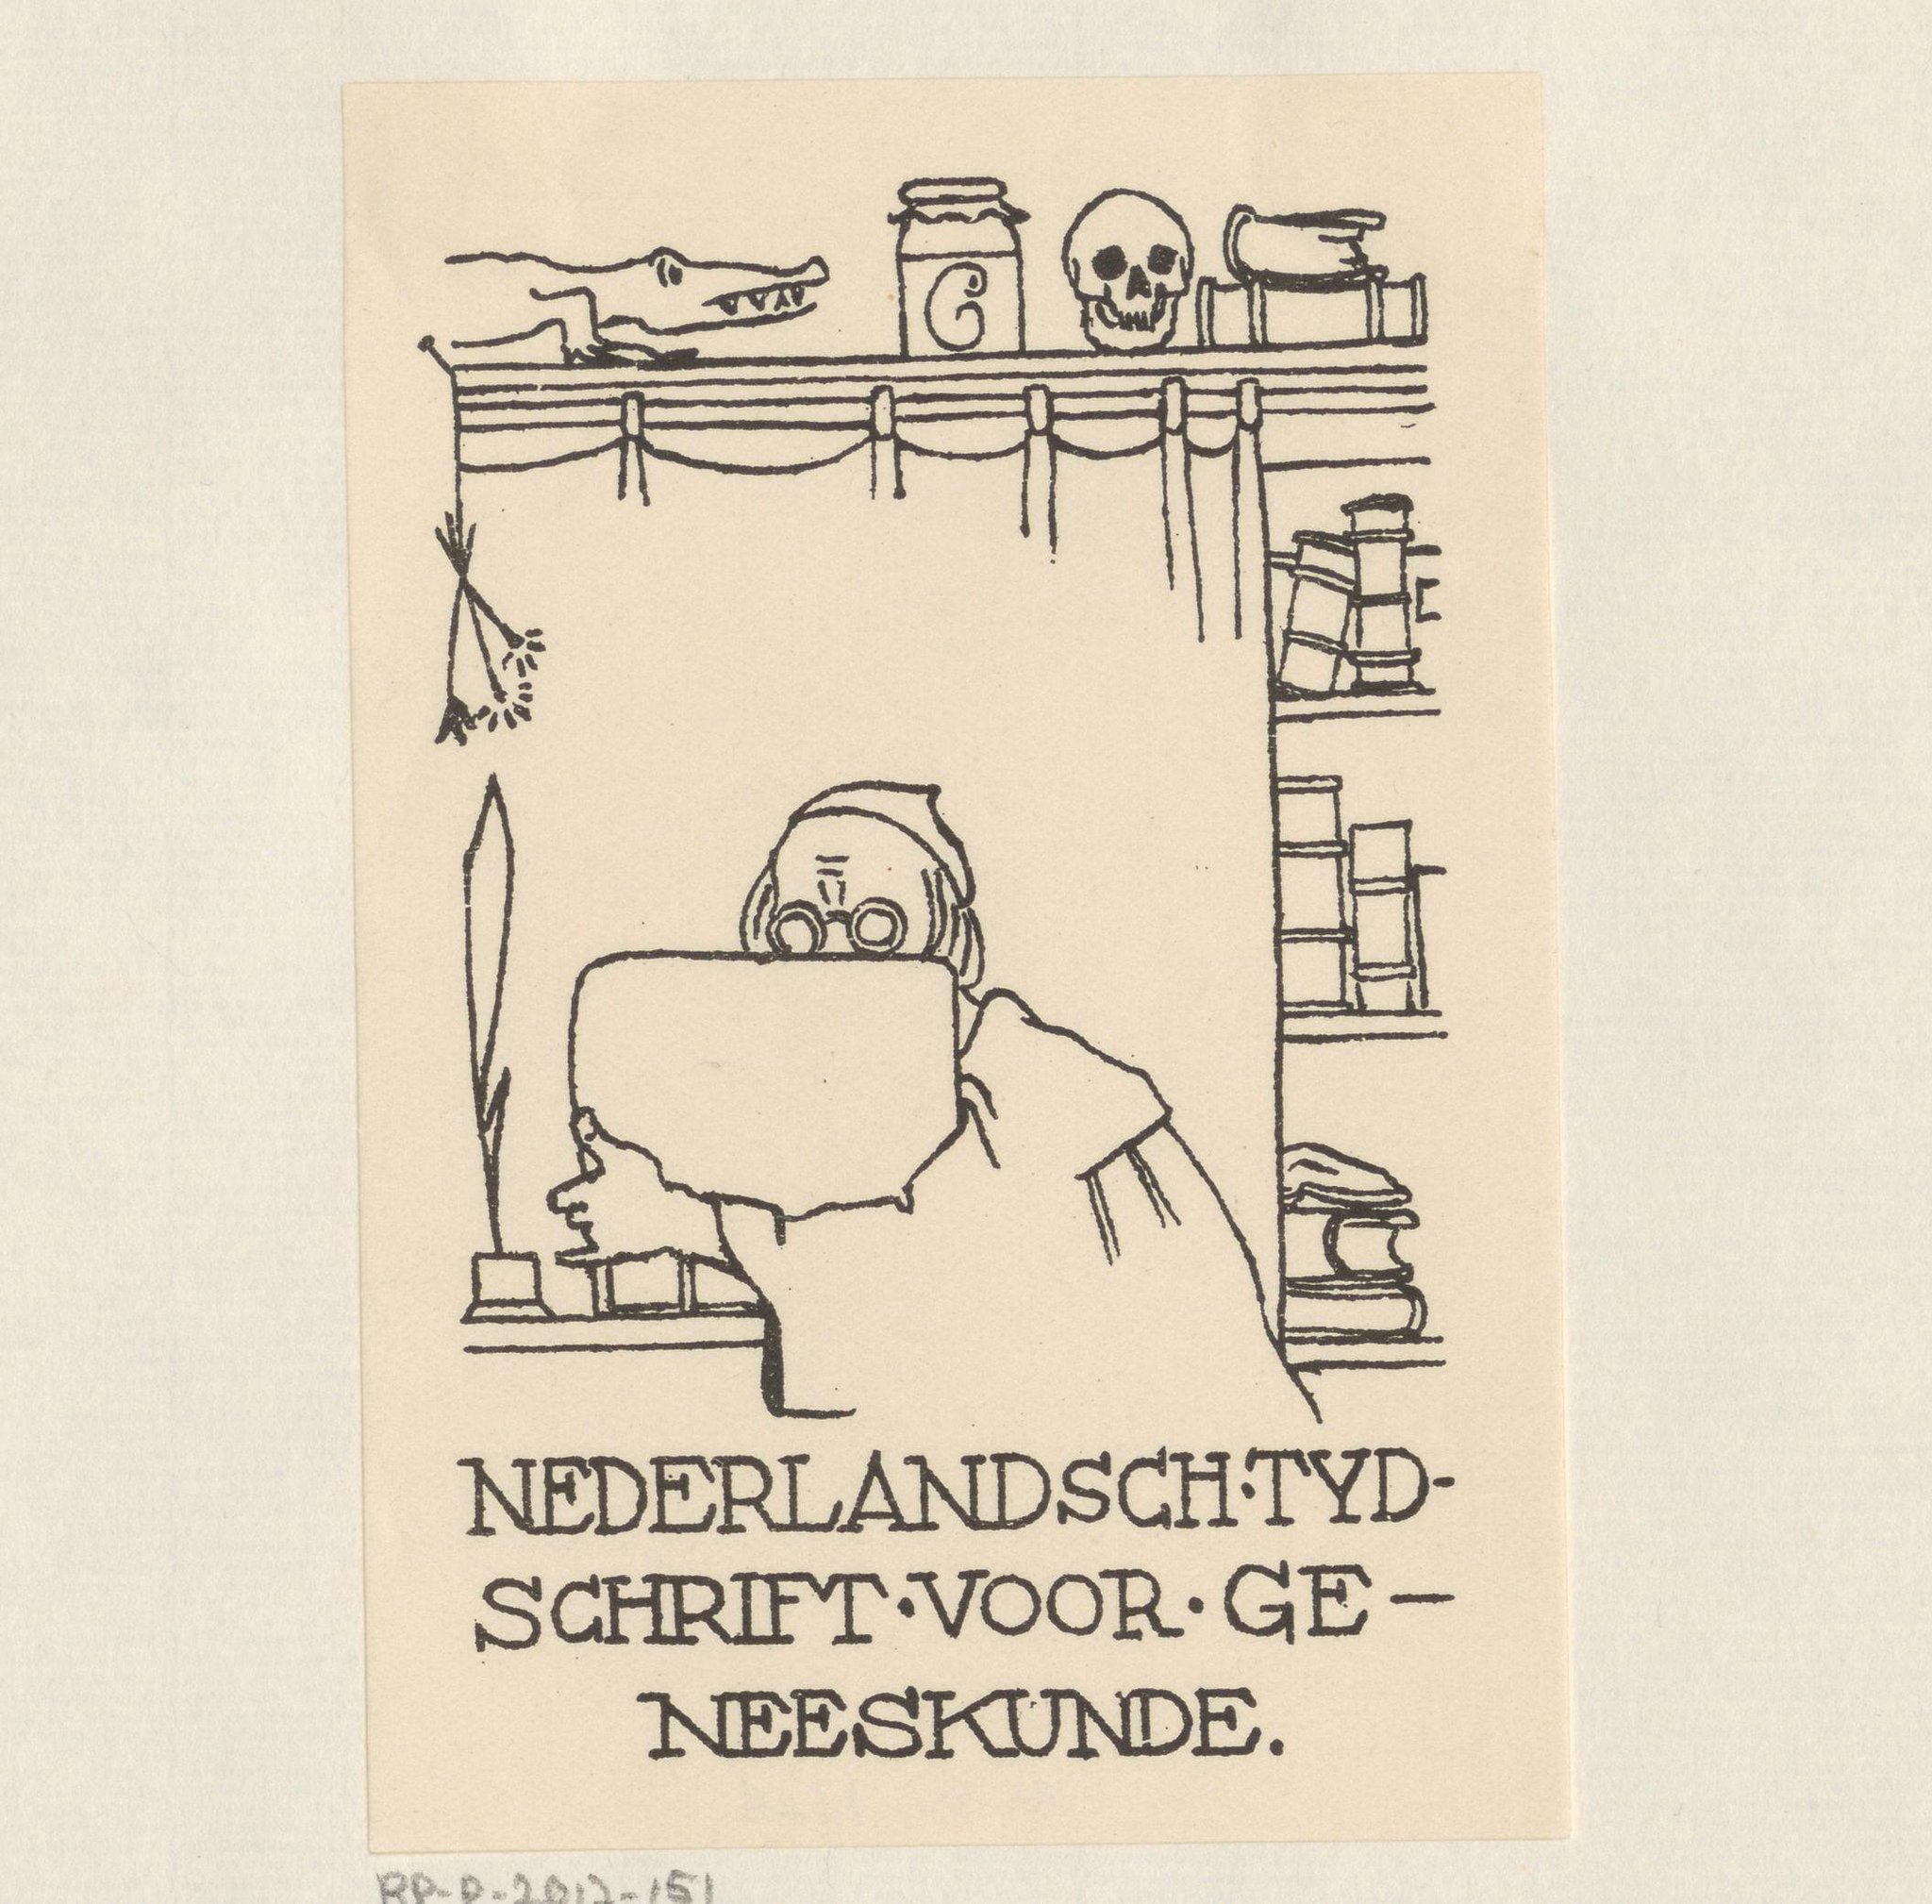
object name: bookplate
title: Ex libris van het Nederlandsch Tijdschrift voor Geneeskunde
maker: a.f. holleman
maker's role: print maker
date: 1928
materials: paper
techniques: printing block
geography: netherlands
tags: scholar in his study, historical costume, medicine, medical science